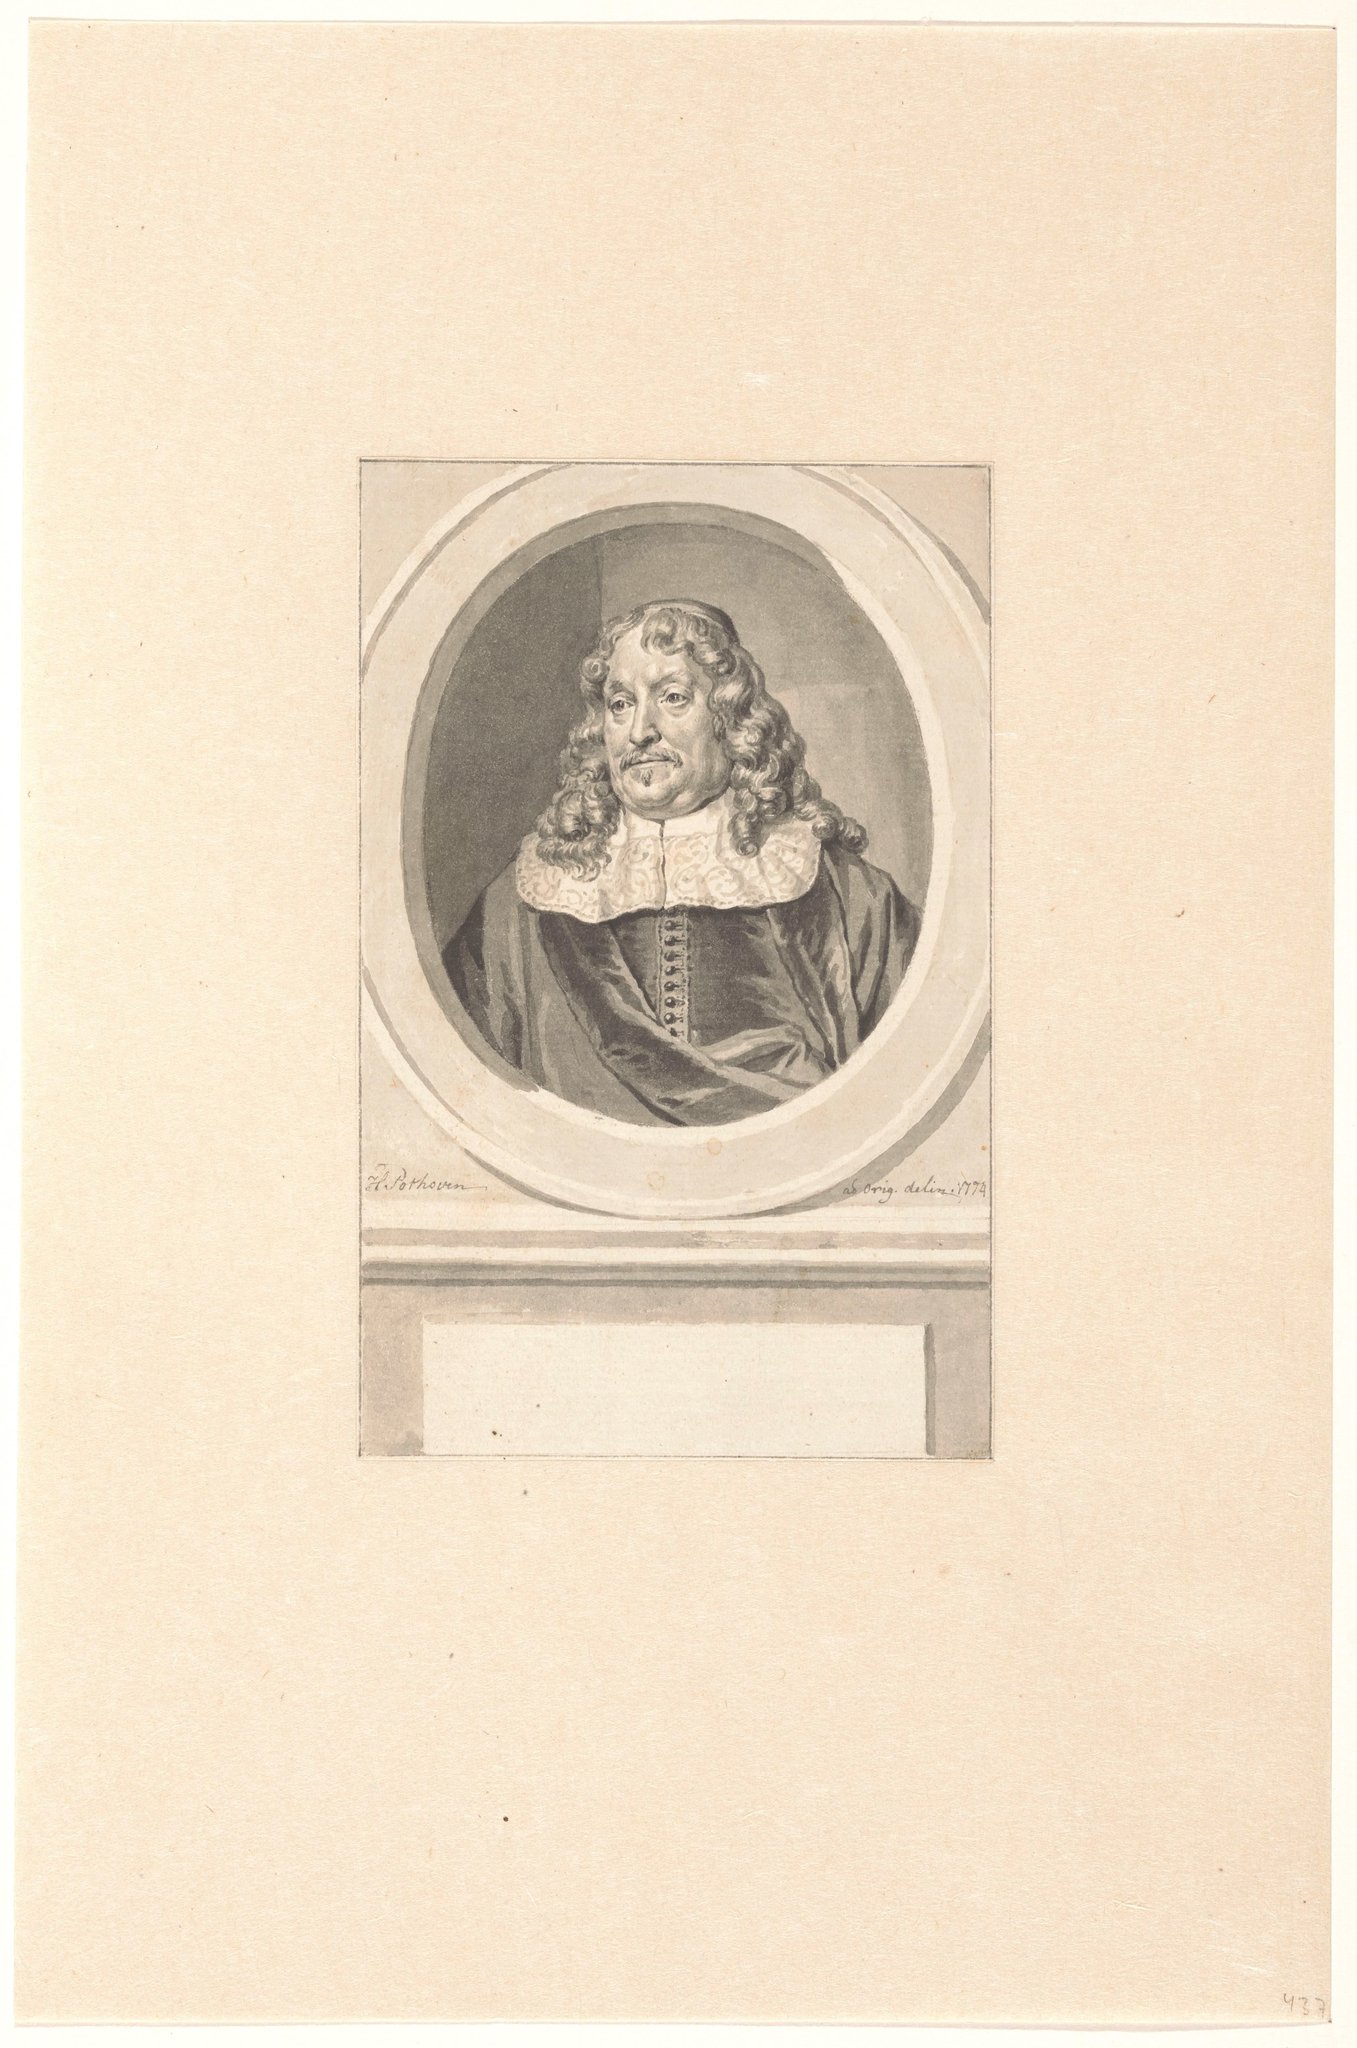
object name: drawing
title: Portret van Andries de Graeff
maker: hendrik pothoven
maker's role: draughtsman, painter, print maker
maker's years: 1725-1807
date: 1774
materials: ink, paper, pencil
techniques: brush, pen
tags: historical persons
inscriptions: signature and date: ‘H. Pothoven / ad orig. delin. 1774’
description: Portret van Mr. Andries de Graeff (1611-1678). Ontwerp voor een prent.